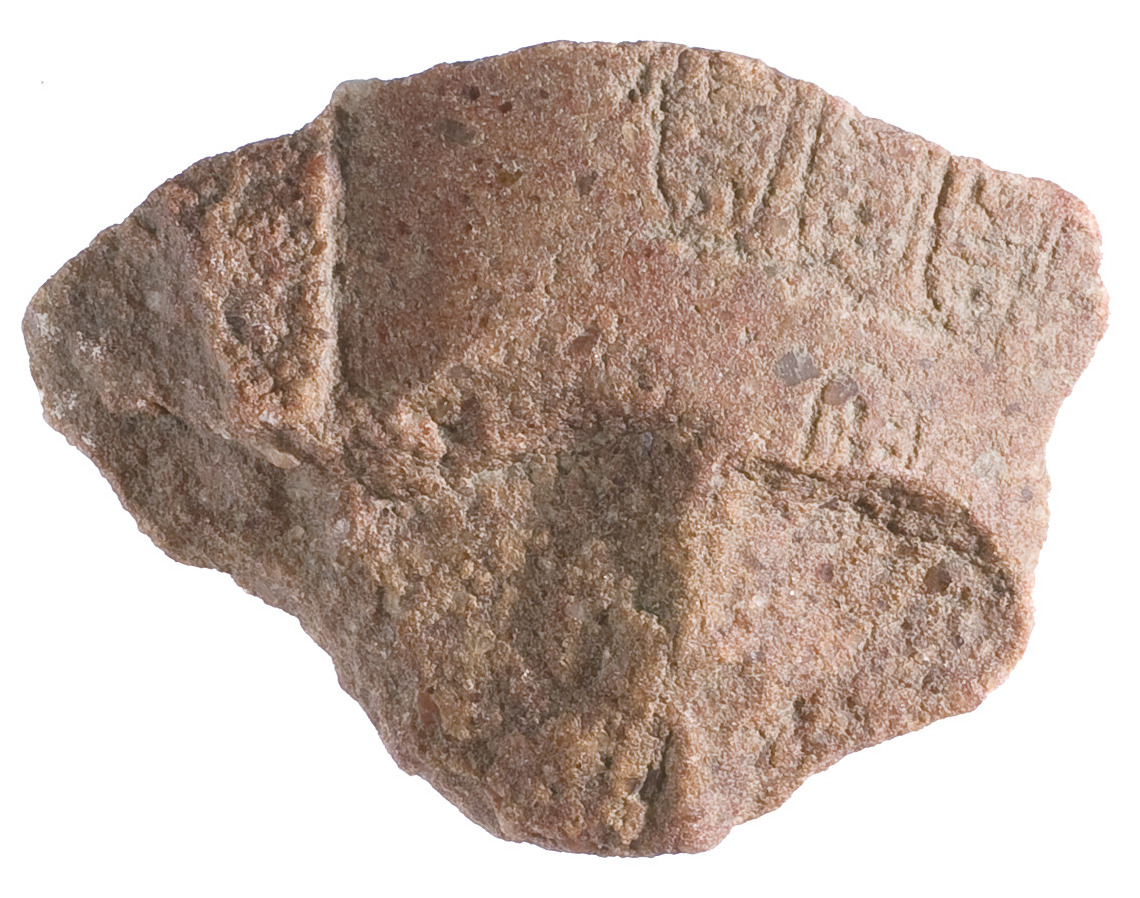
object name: relief chest of king with aten cartouch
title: Chest of king with Aten cartouches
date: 1353-1336 BCE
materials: quartzite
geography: egypt